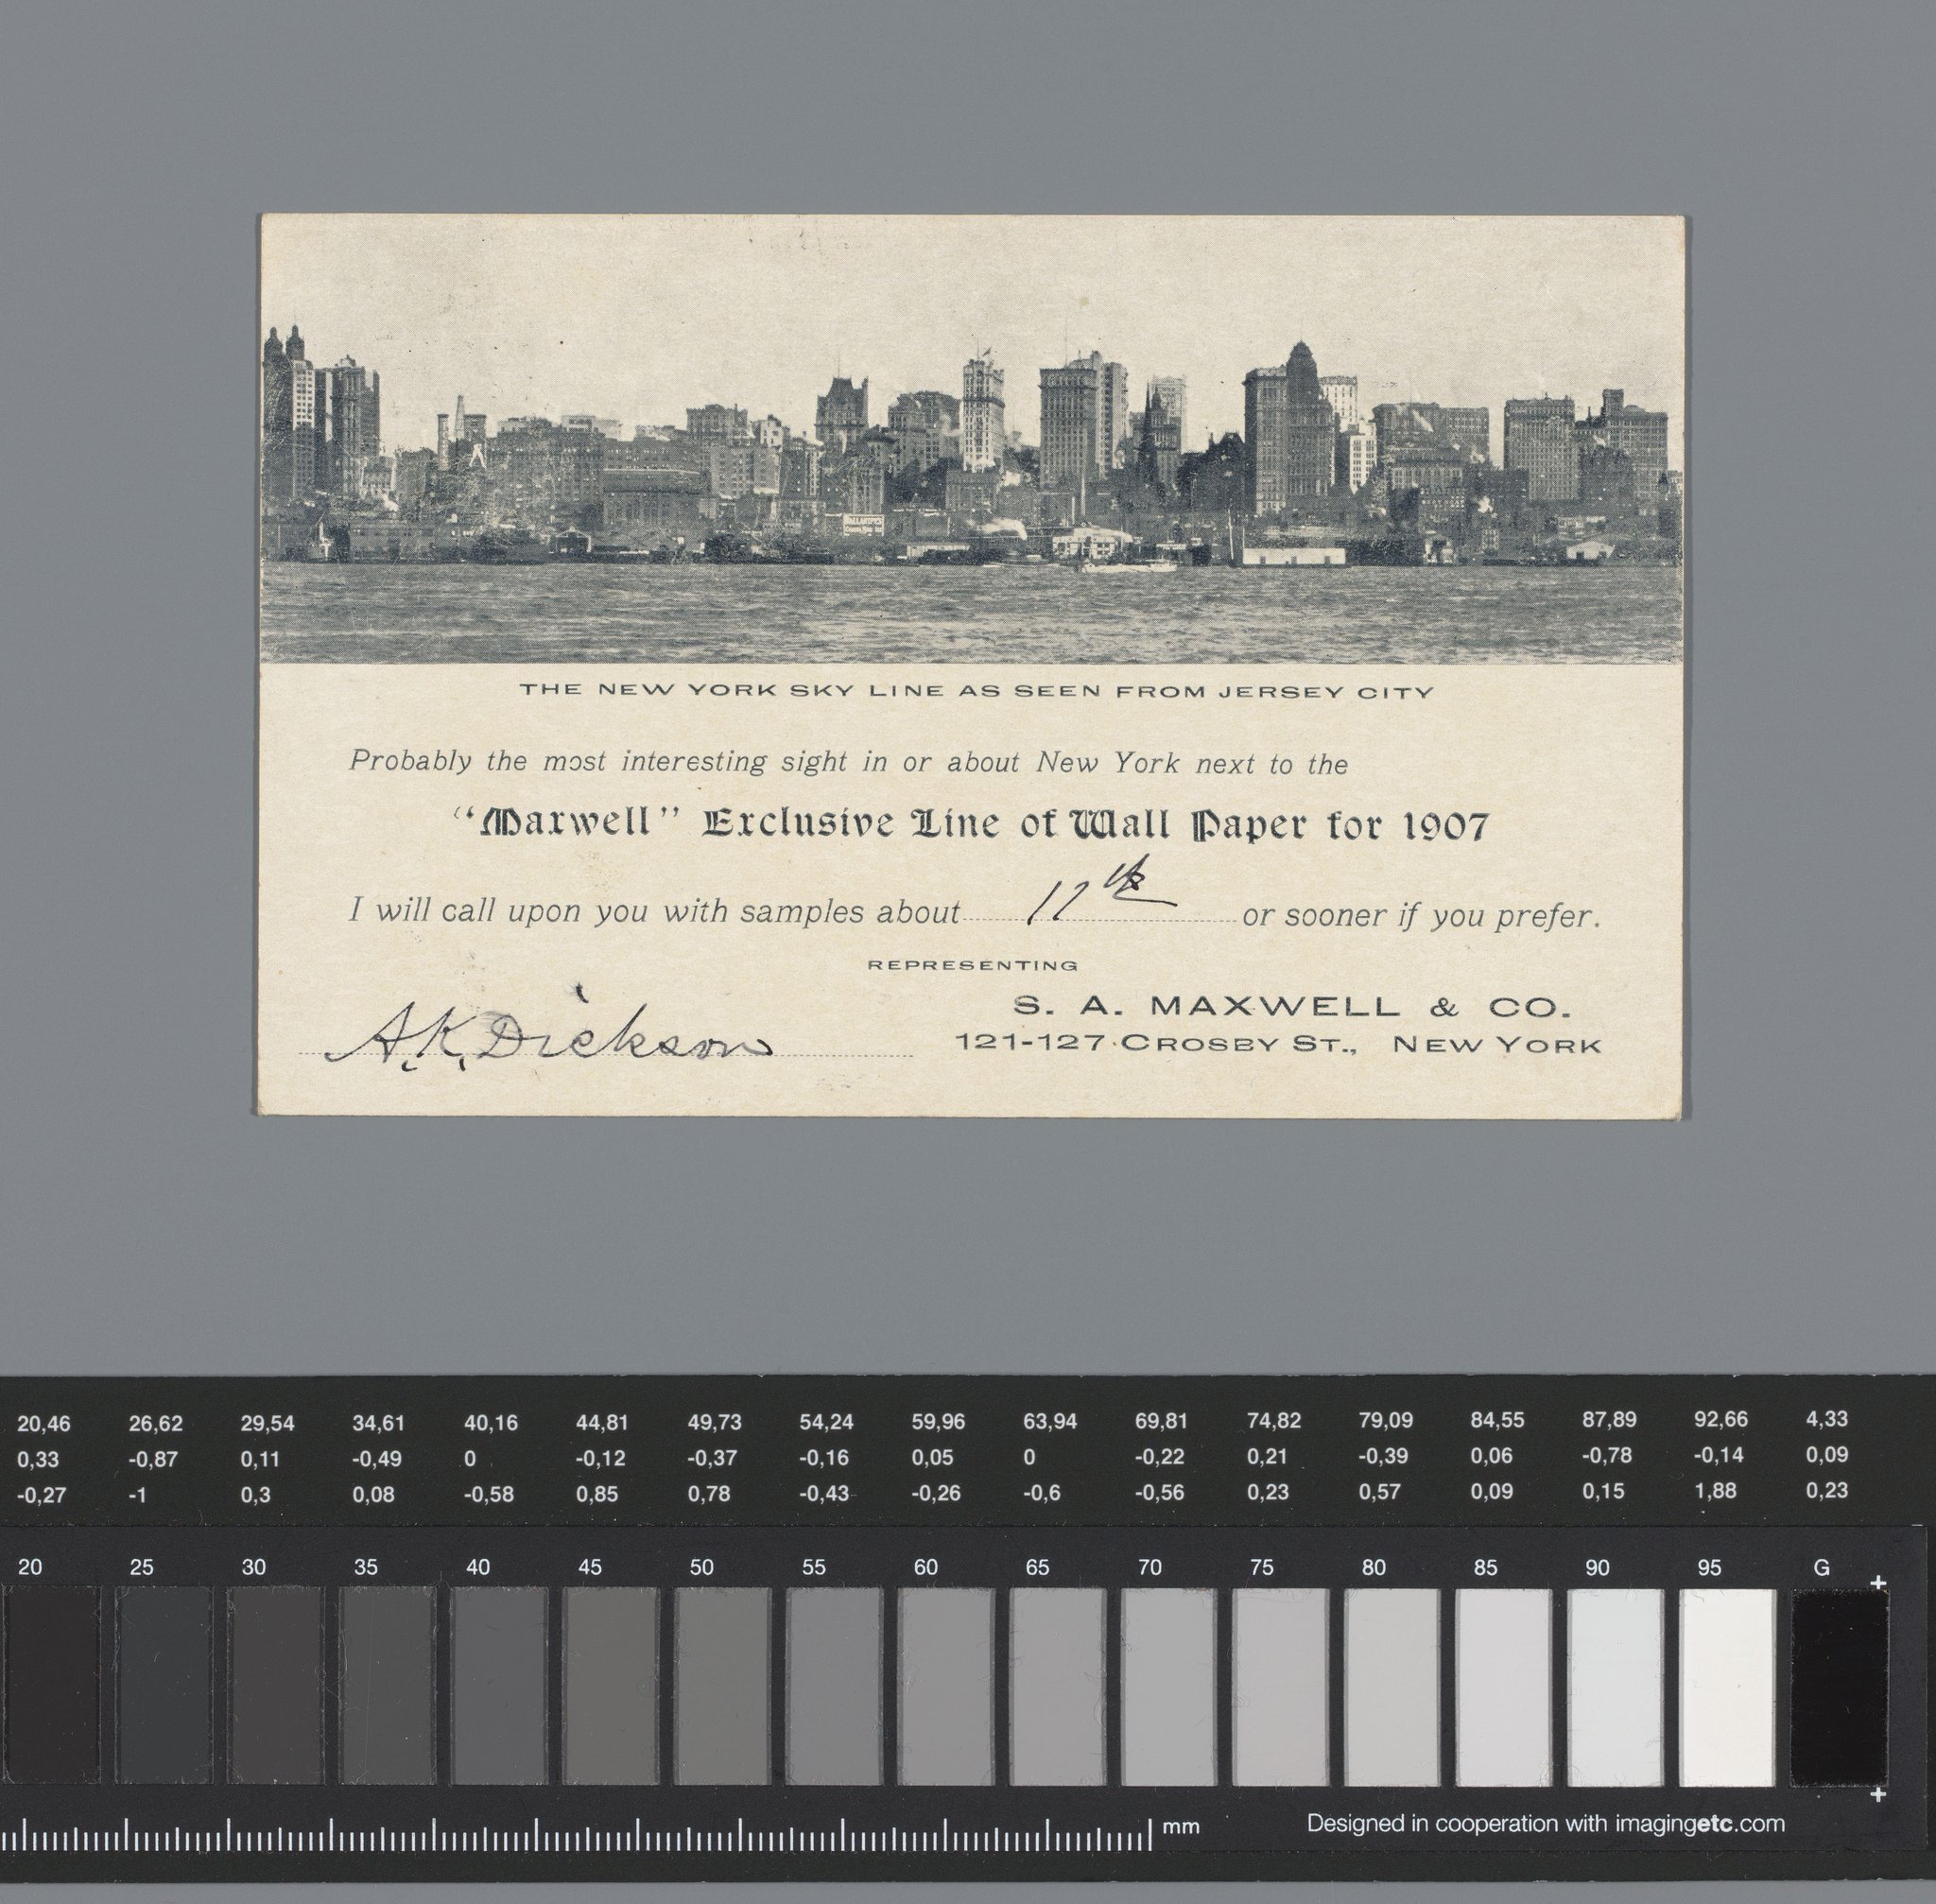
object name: ansichtkaart, prentbriefkaart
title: Reclame voor een behangselfabrikant met aankondiging van een vertegenwoordiger van Maxwell behang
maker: Anonymous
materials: photographic support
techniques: autotype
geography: united states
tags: new york (city)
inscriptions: inscription: ‘THE NEW YORK SKY LINE AS SEEN FROM JERSEY CITY / Probably the most interesting sight in or about New York next to the / “MAXWELL” EXCLUSIVE LINE OF WALL PAPER FOR 1907 / I will call upon you with samples about [in pen: 11th] or sooner if you prefer. [in pen: A. K. Dickson]/ REPRESENTING / S.A.MAXWELL & CO. / 121 – 127 Crosby St. New York’, stamp: ‘1906’